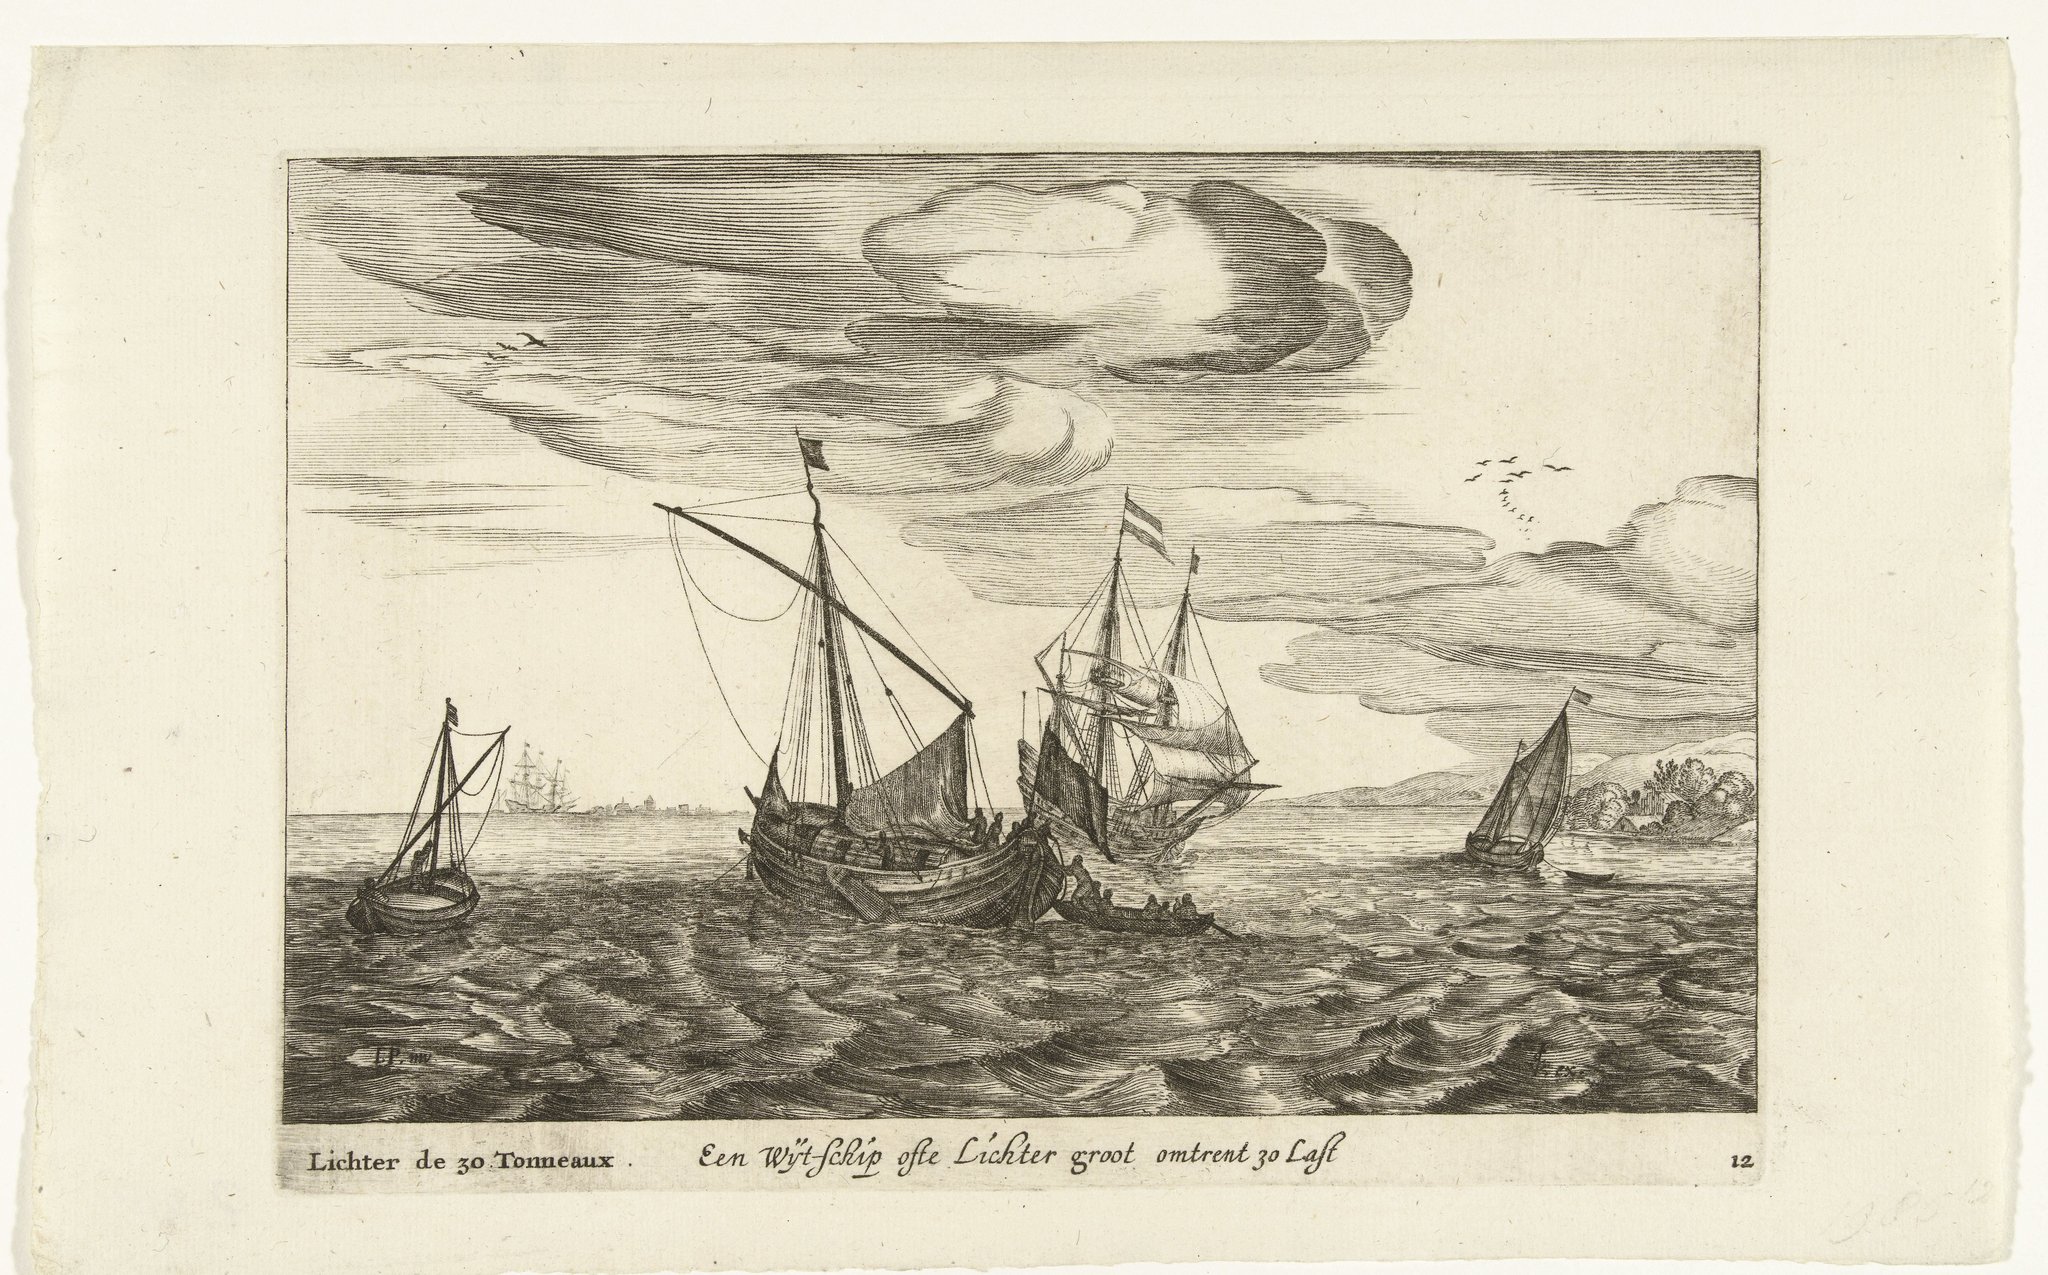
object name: print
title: Een Wyt-schip ofte Lichter groot omtrent 30 Last / Lichter de 30 Tonneaux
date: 1627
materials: paper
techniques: engraving, etching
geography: northern netherlands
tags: sailing-ship, sailing-boat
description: Een wijdschip of lichter op het water. Prent nr. 12 in een serie prenten van Hollandse scheepstypen, 1627. .